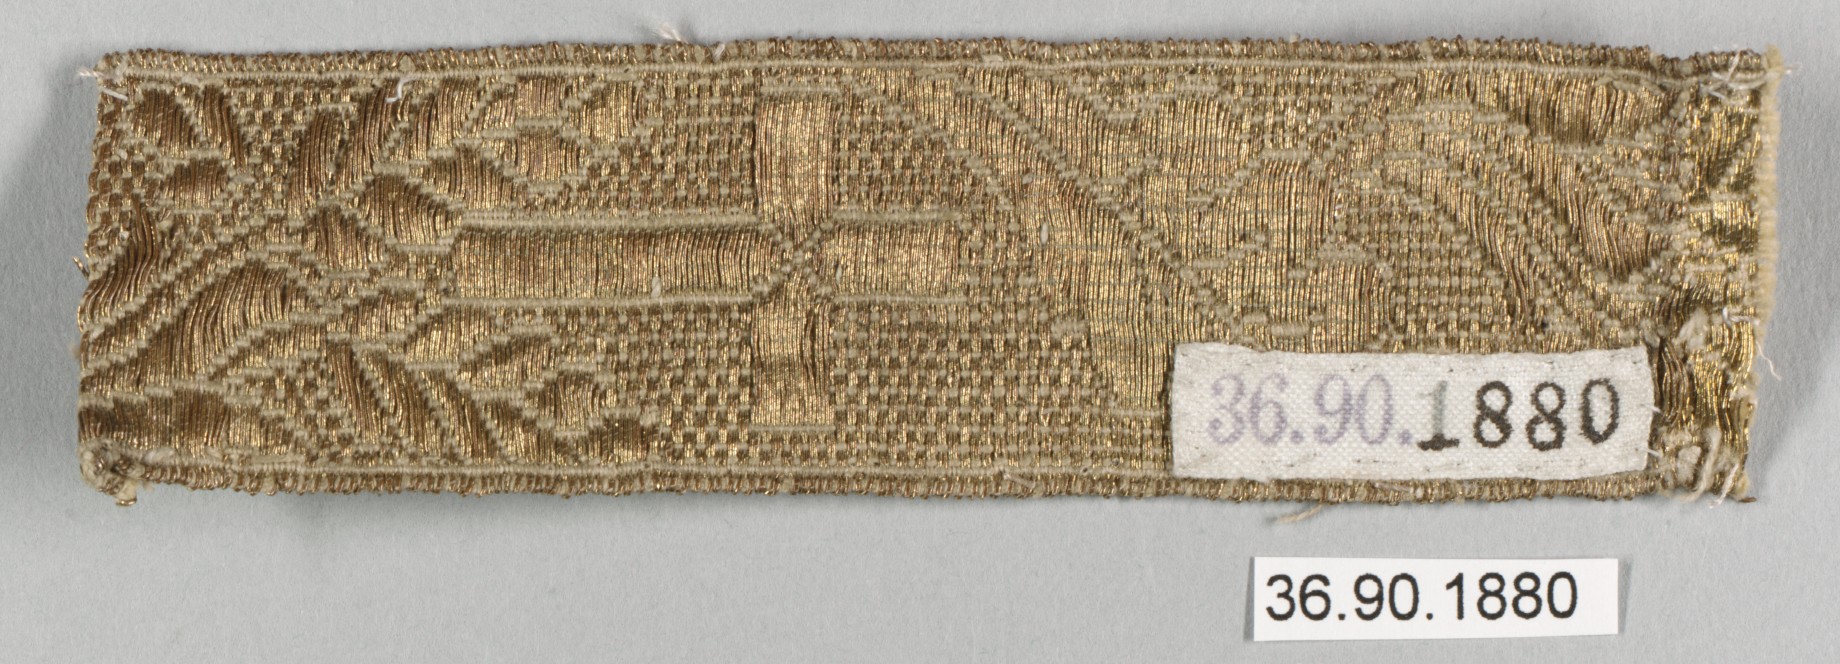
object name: galloon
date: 1767-1833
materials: cotton, metal thread